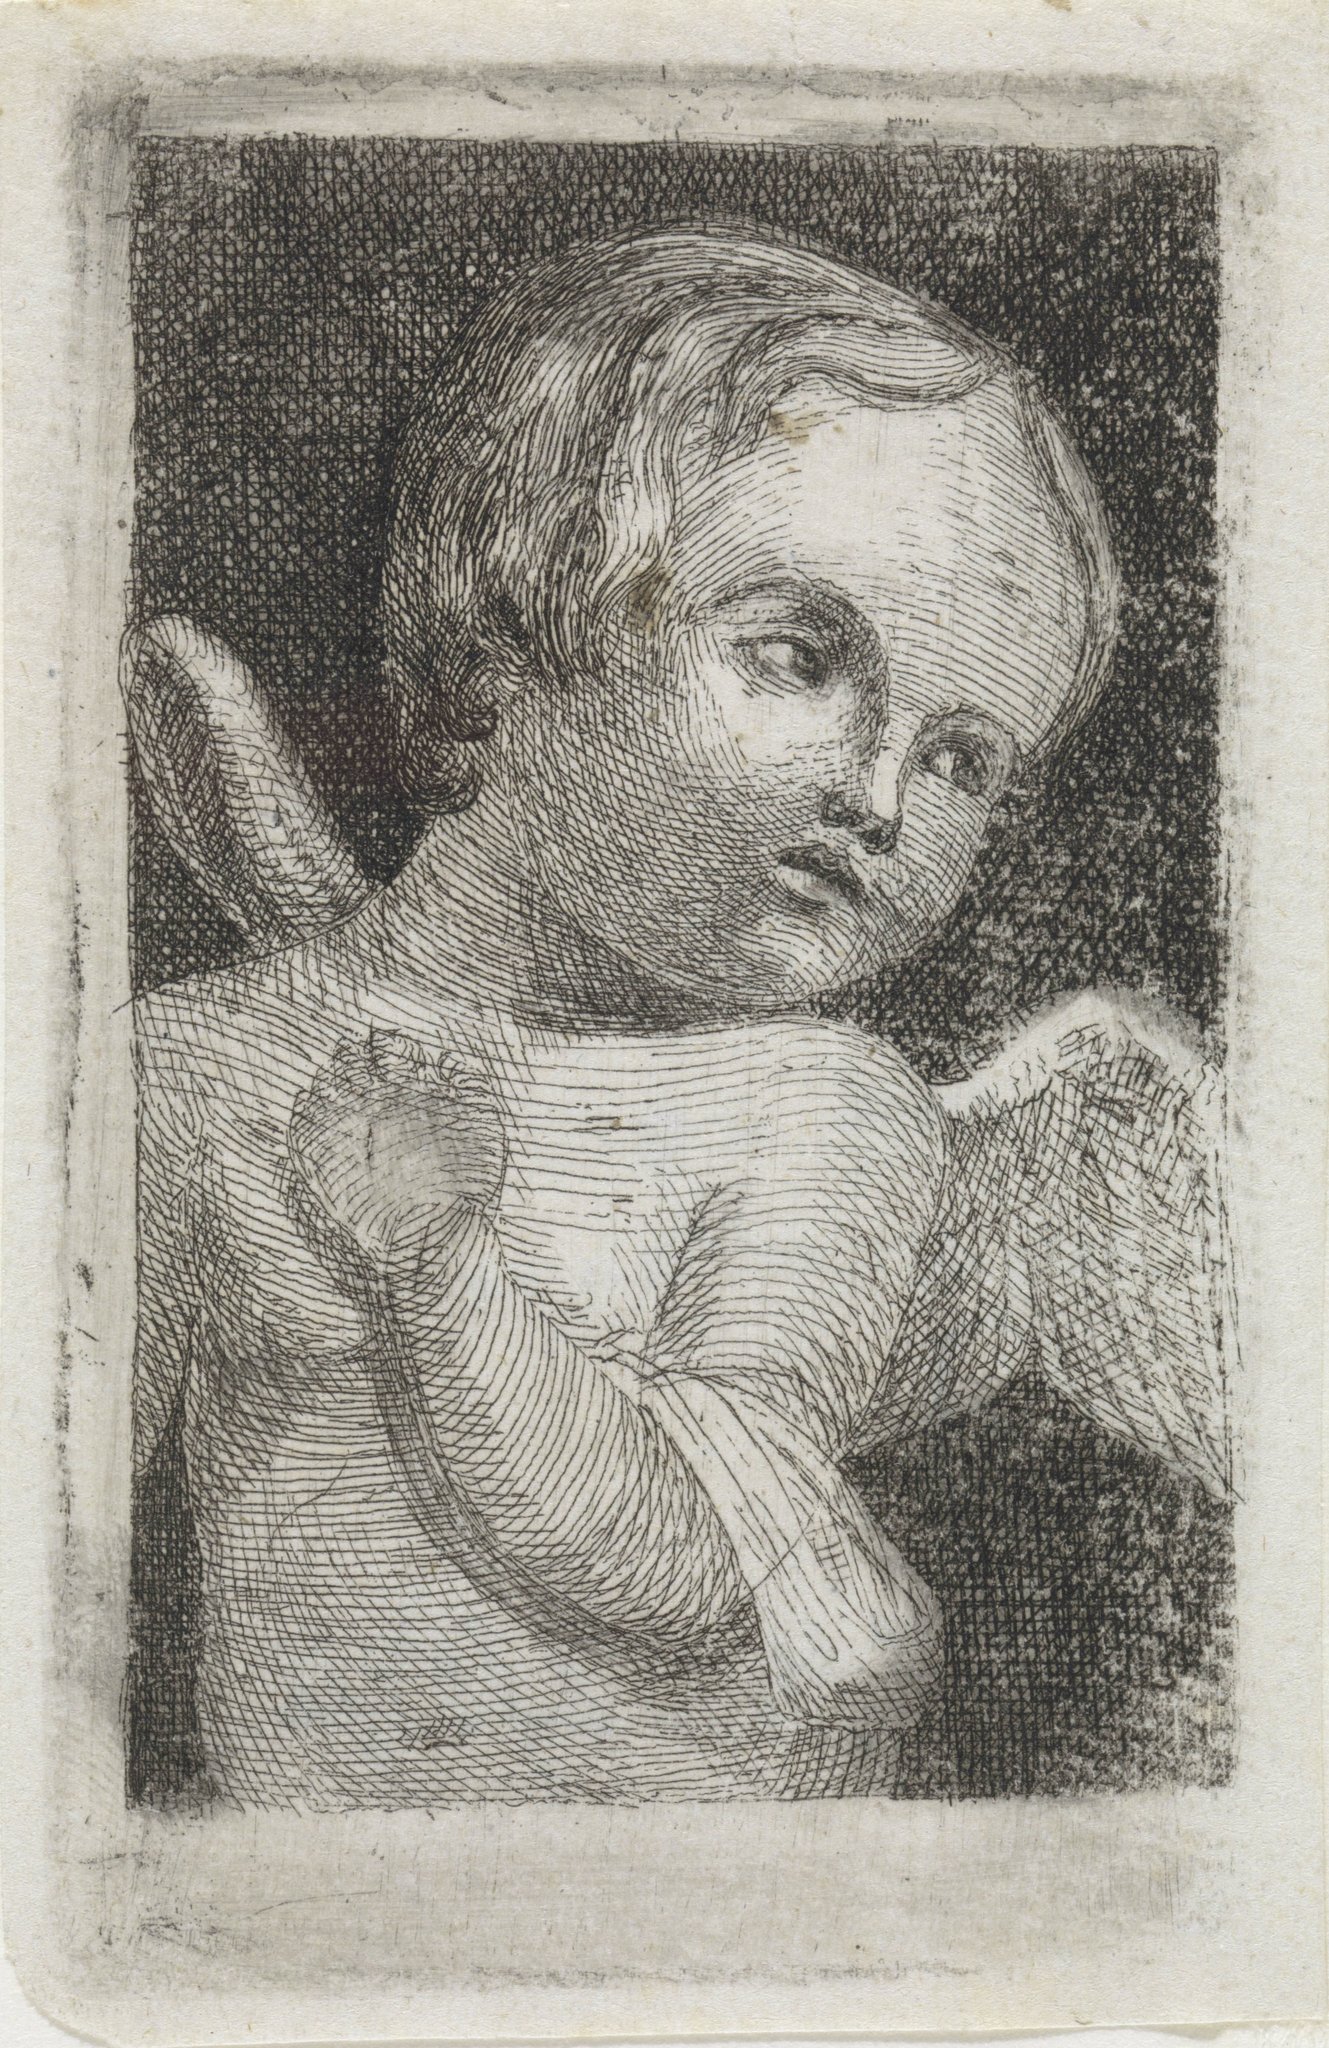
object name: print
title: Borstbeeld van een engel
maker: arnoud schaepkens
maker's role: print maker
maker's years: 1816-1904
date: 1831-1904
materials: paper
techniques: etching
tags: angels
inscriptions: collector's mark: Lugt 2228